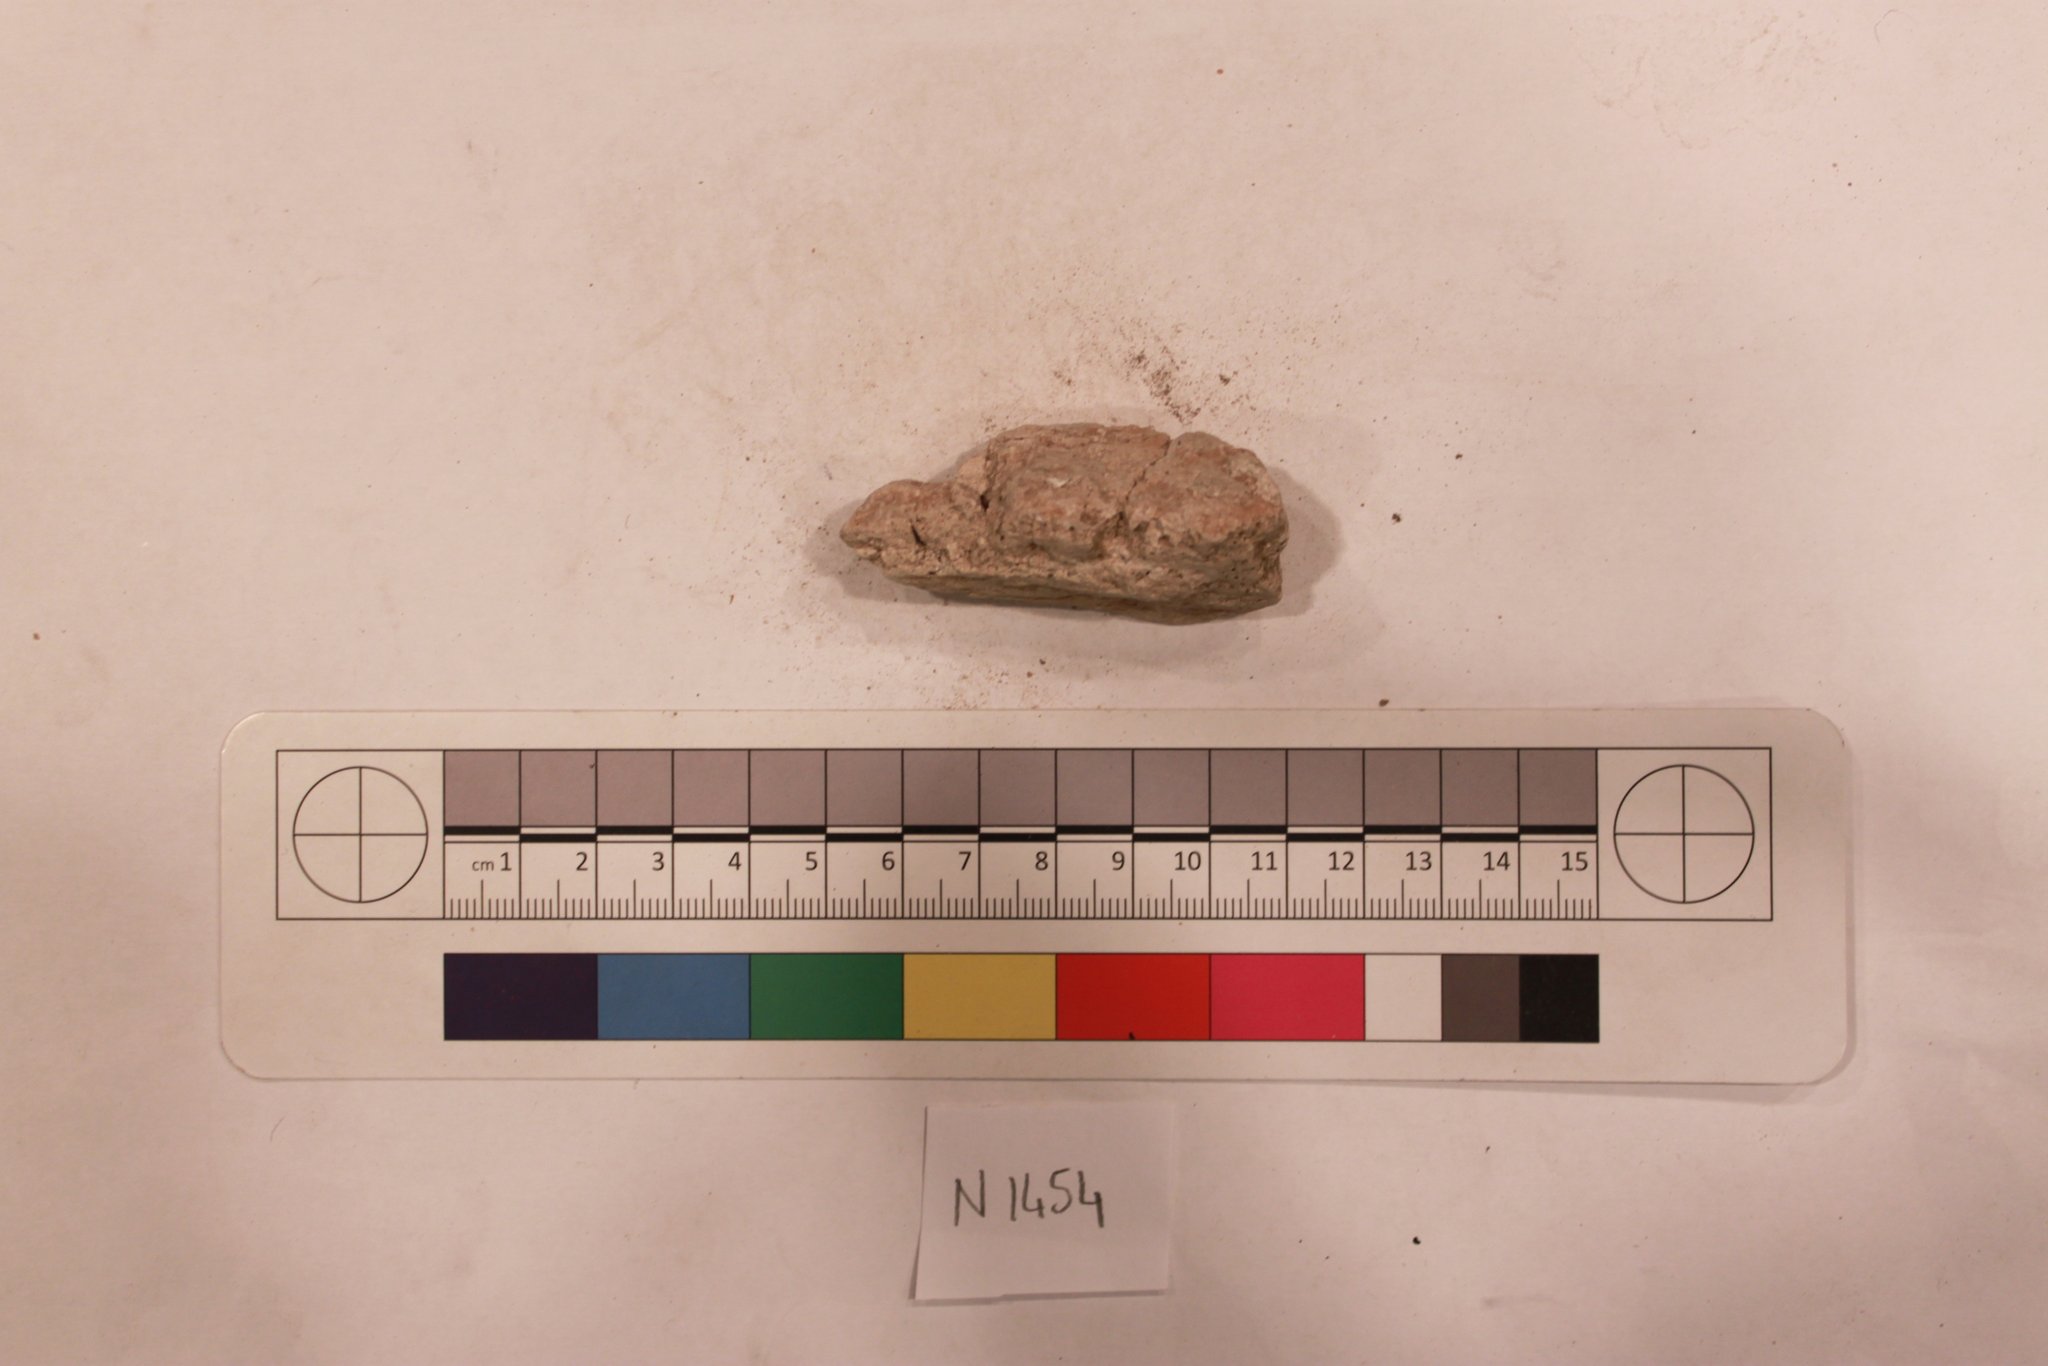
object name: fragment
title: Stucco Fragment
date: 701-1200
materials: plaster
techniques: carving, painting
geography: iran